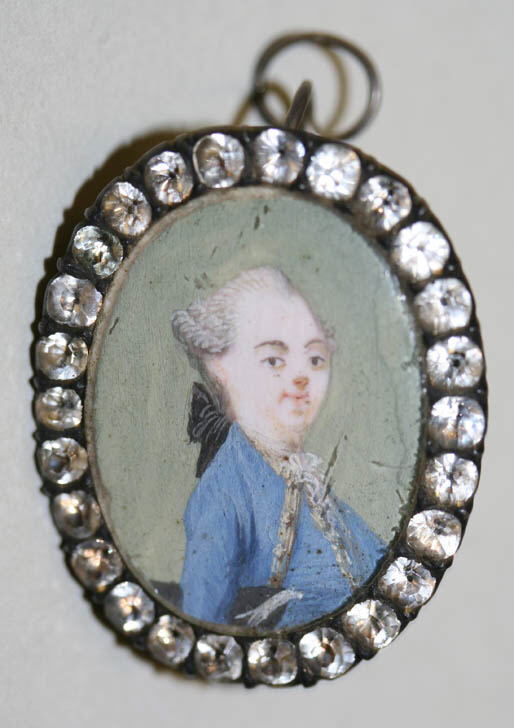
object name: earring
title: Earrings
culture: french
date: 1701-1800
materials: metal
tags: men,portraits